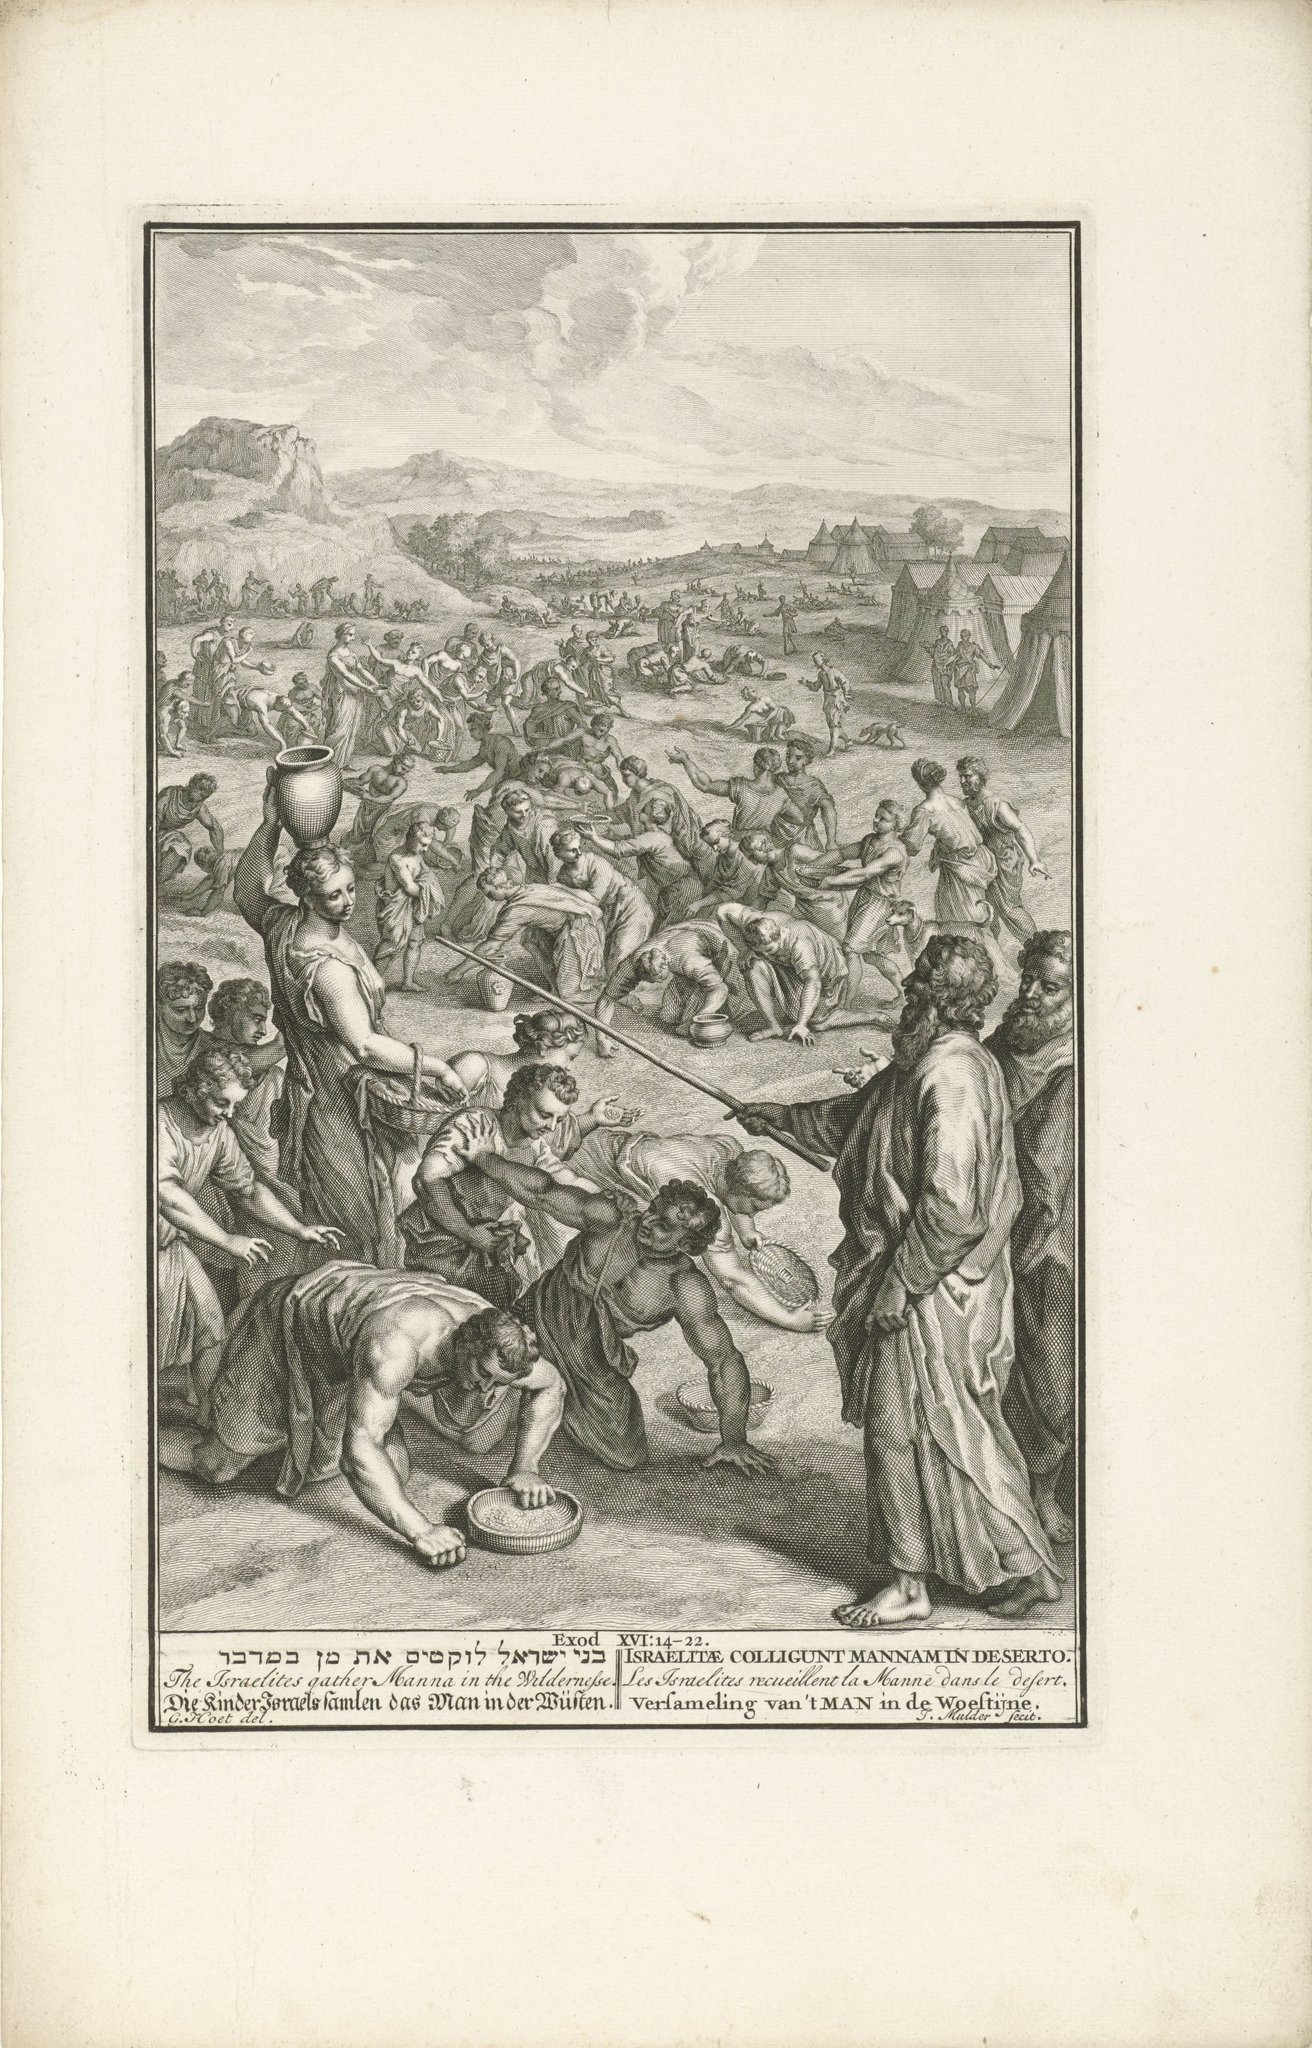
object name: book illustration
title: Verzamelen van het manna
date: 1720-1728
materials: paper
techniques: engraving, etching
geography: amsterdam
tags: the gathering of manna (in baskets and pots)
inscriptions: collector's mark: Lugt 2228, inscription: ‘Utrechts Fundatie huijs’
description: Prent gemaakt voor: Figures de la Bible. Amsterdam, Bernard Picart, 1720. Prent ook gebruikt in: Taferelen der voornaamste geschiedenissen van het Oude en Nieuwe Testament (...) door de vermaarde kunstenaars Hoet, Houbraken, en Picart getekent (...) en met beschrijvingen uitgebreid. Den Haag: Pieter de Hondt, 1728.